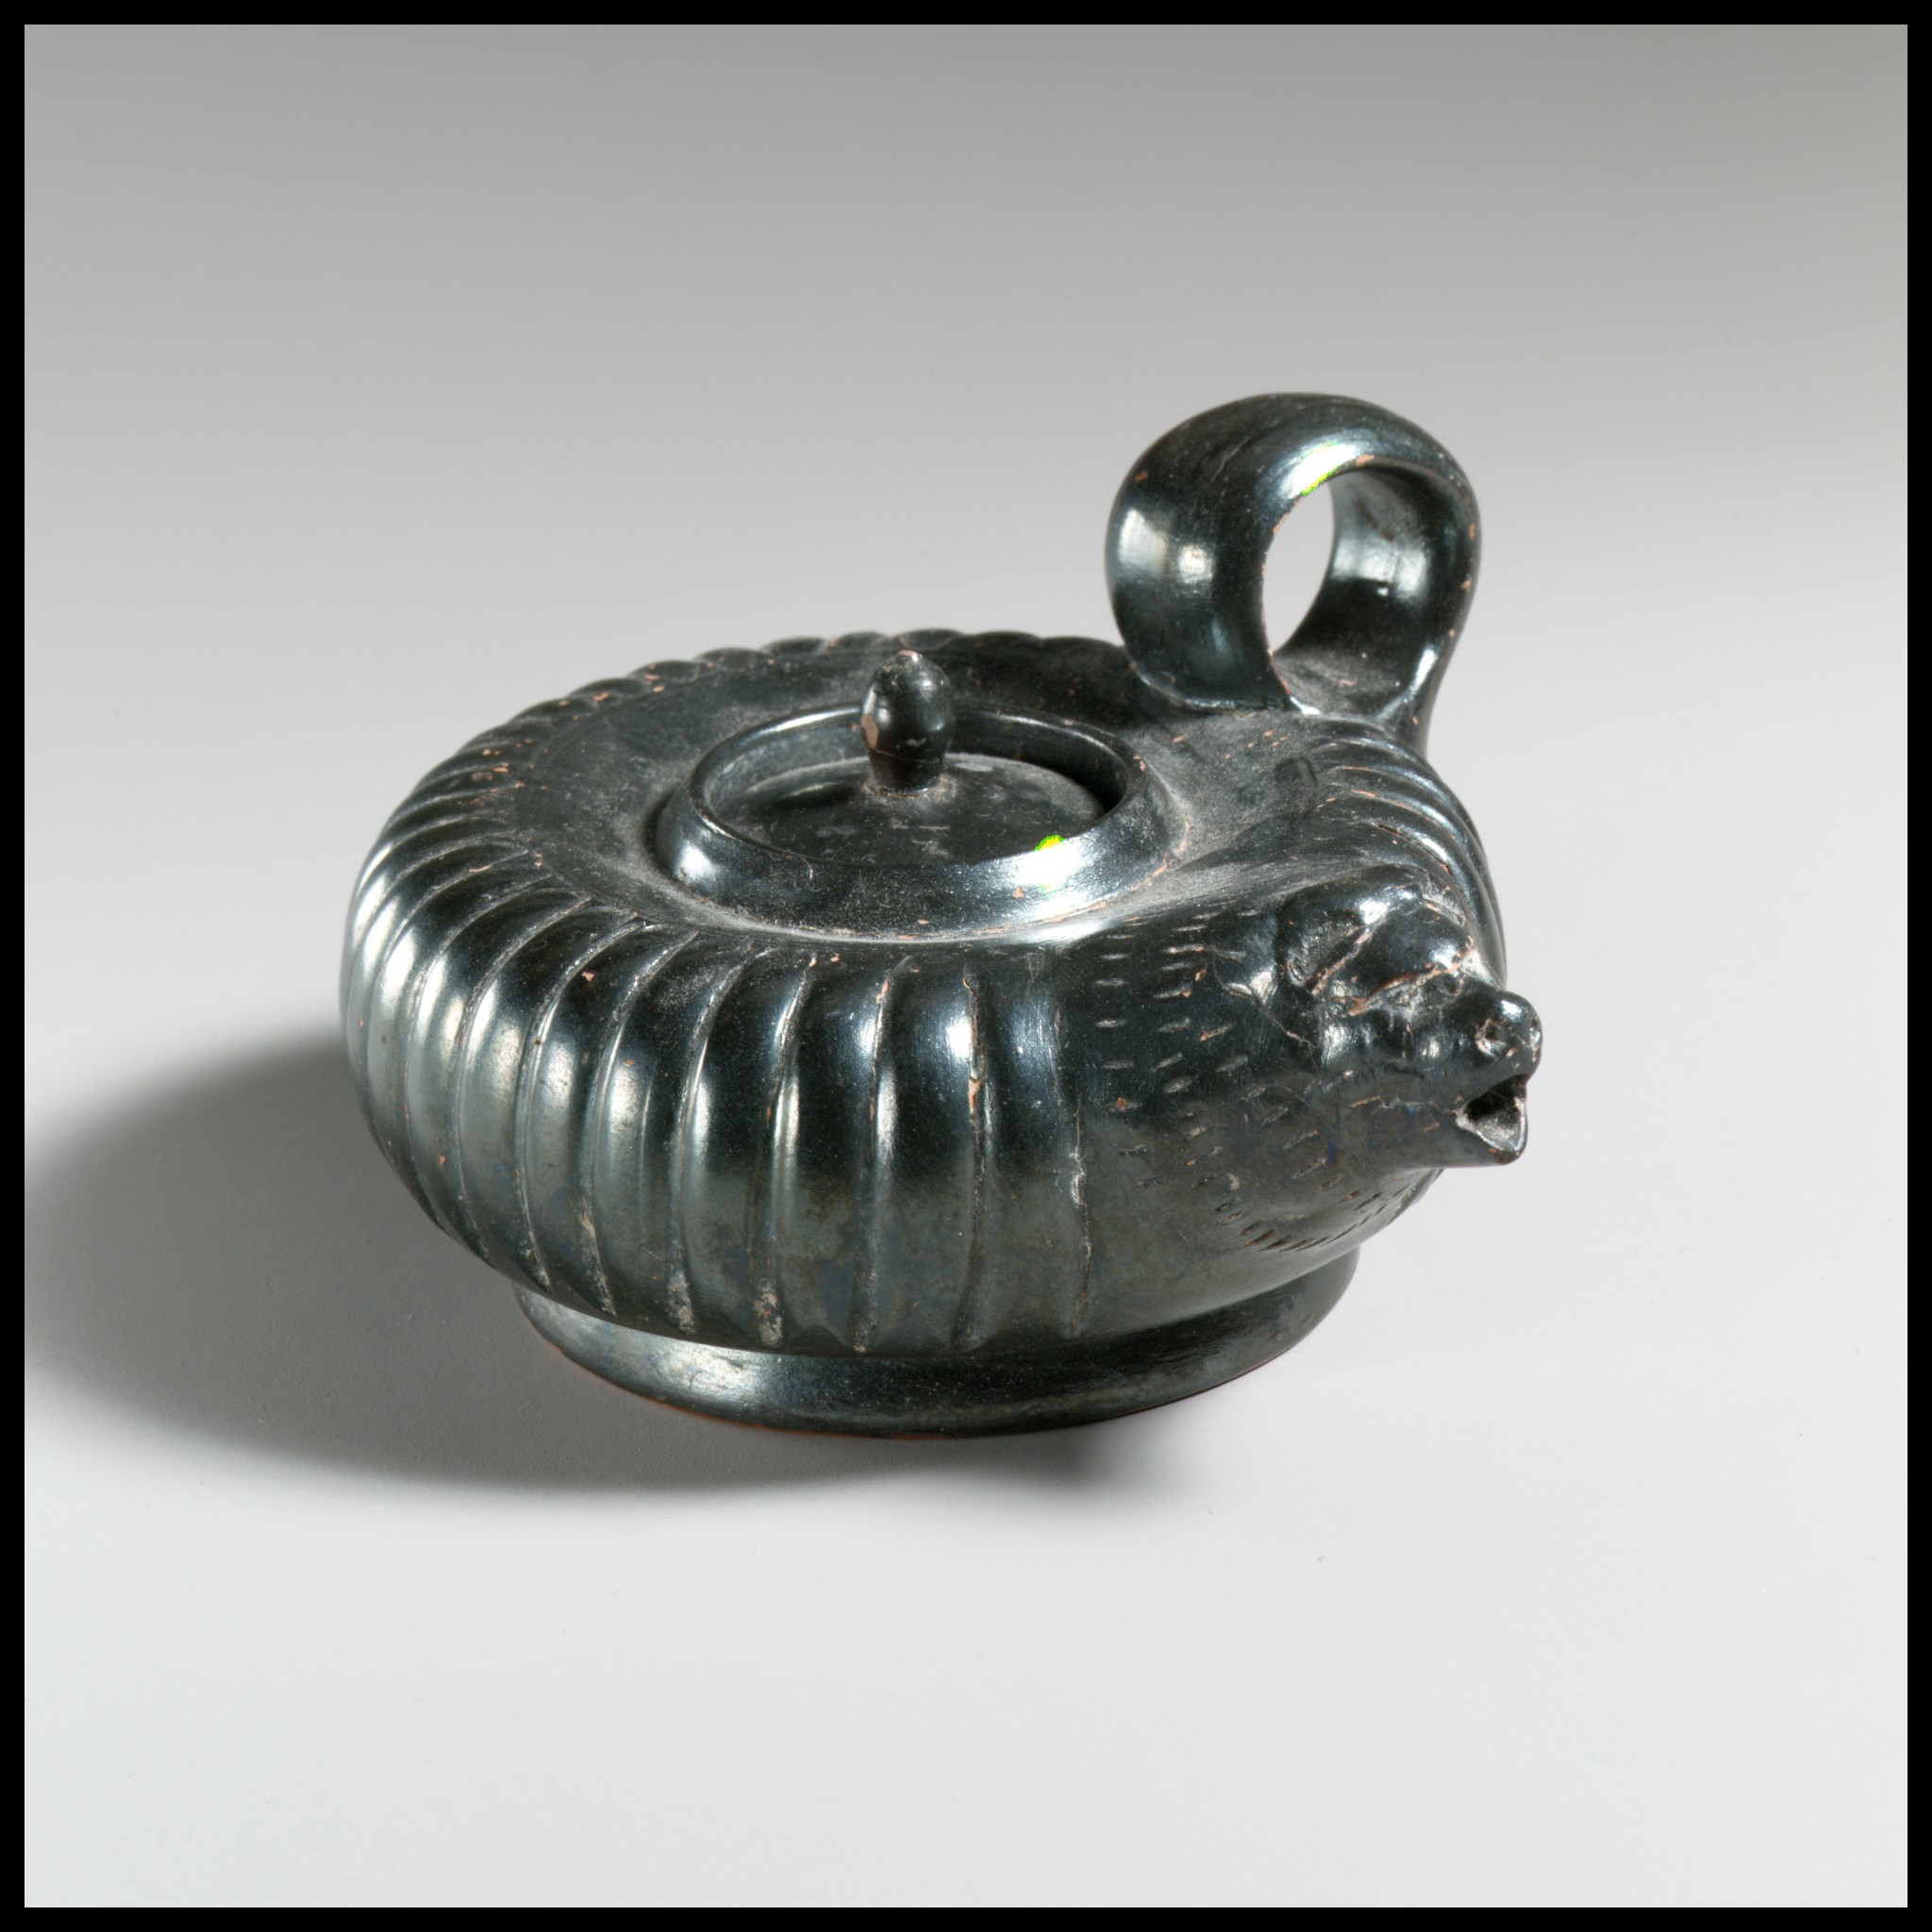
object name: guttus with lid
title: Terracotta guttus with lid (flask with handle and spout)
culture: greek or south italian or campanian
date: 400-301 BCE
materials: terracotta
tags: lions